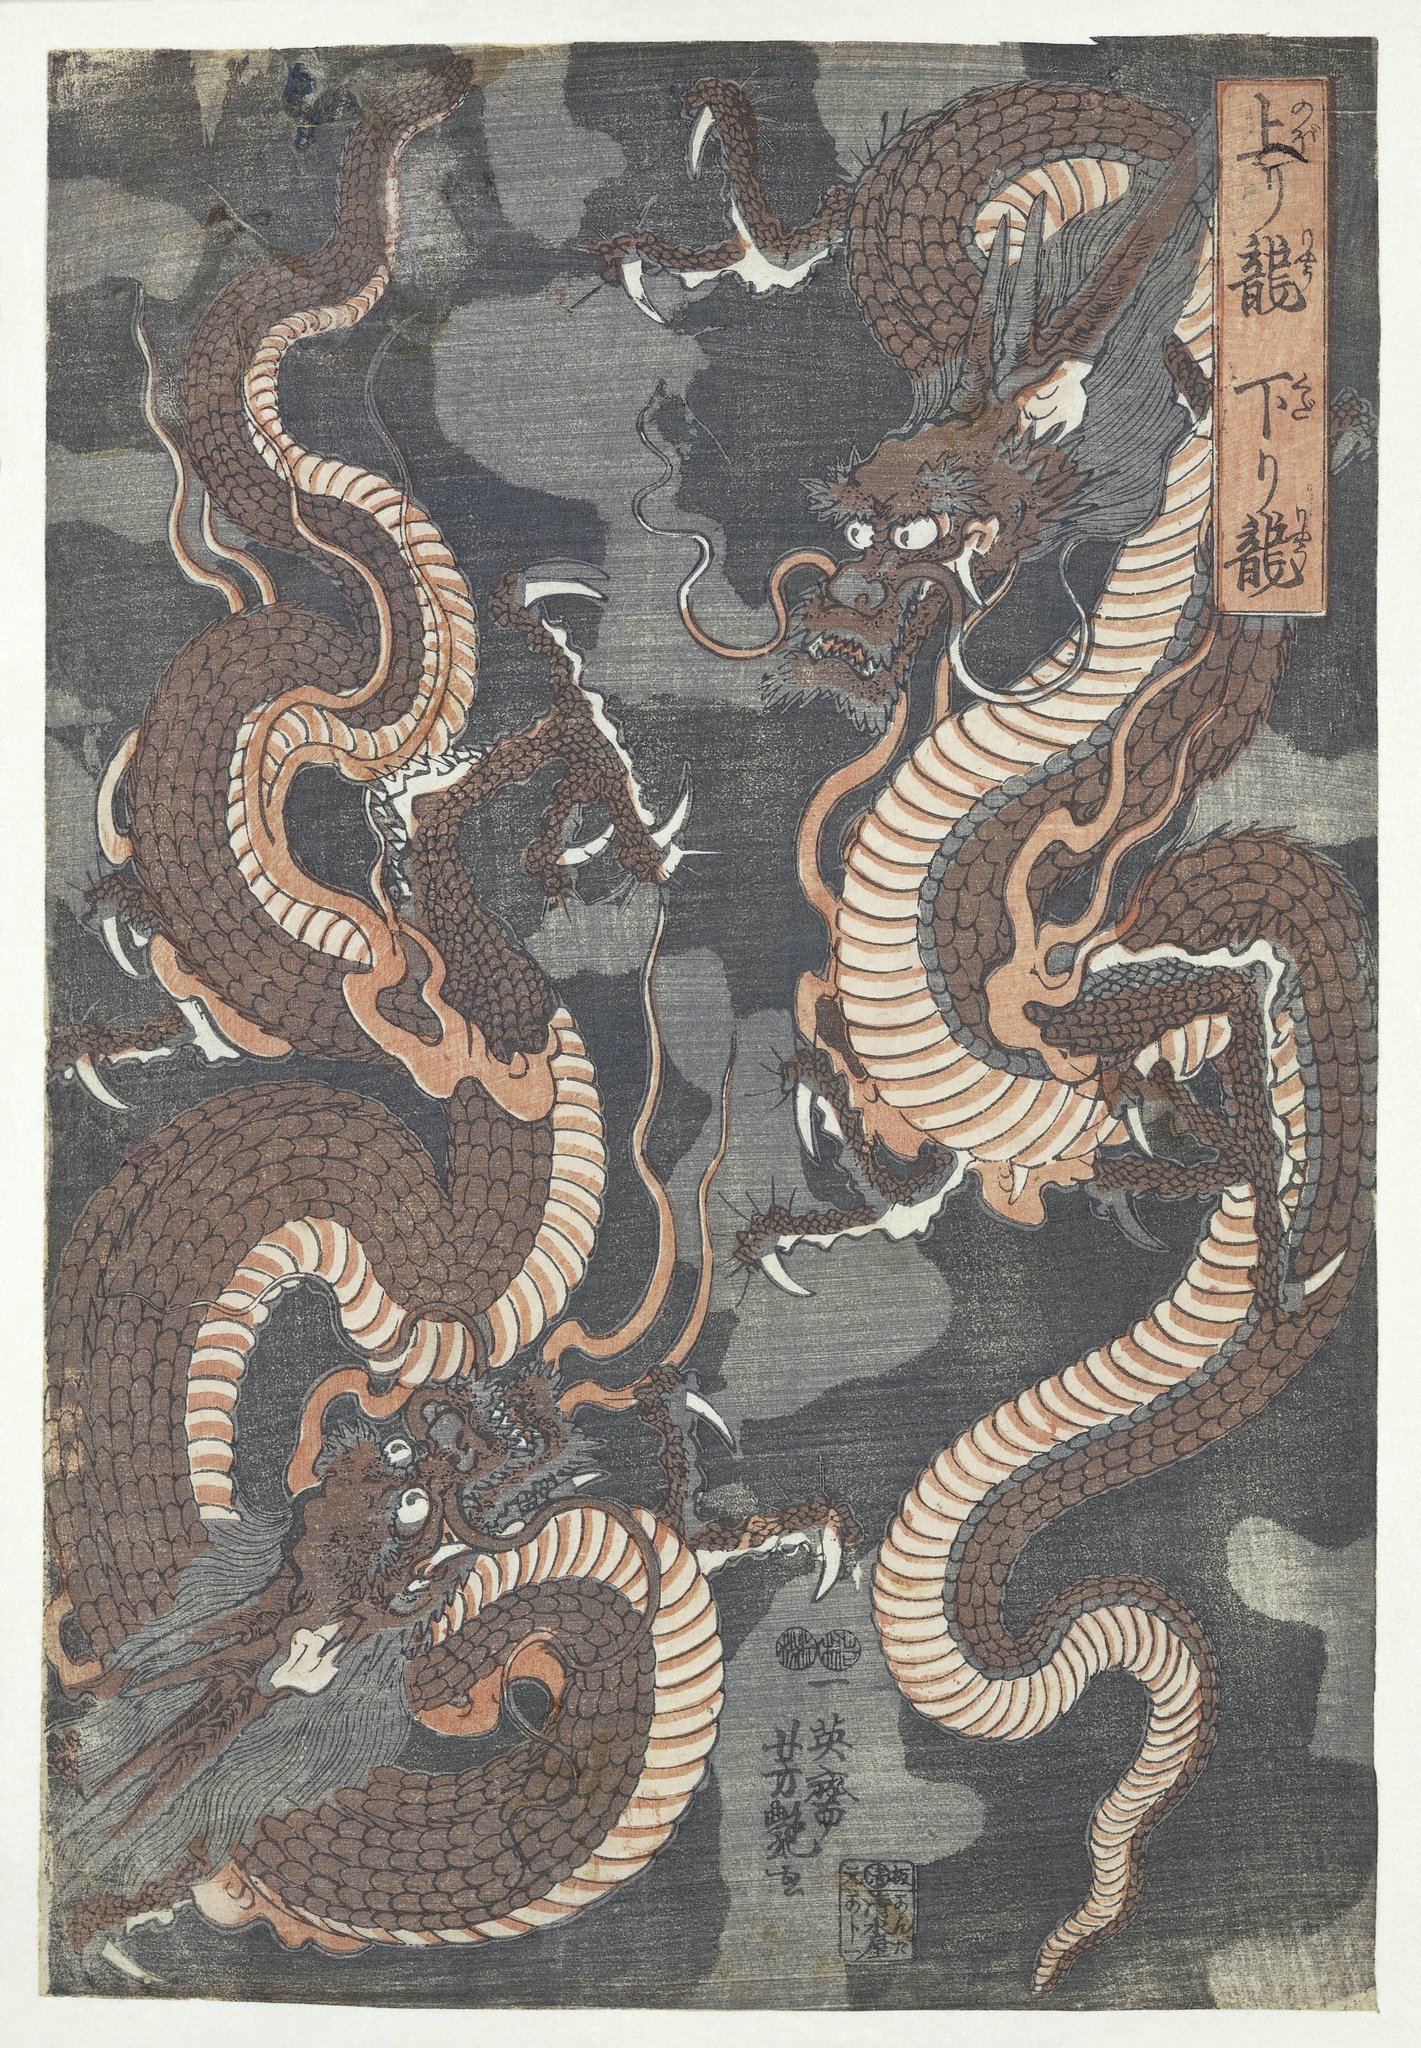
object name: print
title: Twee draken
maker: utagawa yoshitsuya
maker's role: print maker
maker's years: 1822-1866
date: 1843-1847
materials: paper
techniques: woodcut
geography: japan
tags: dragon